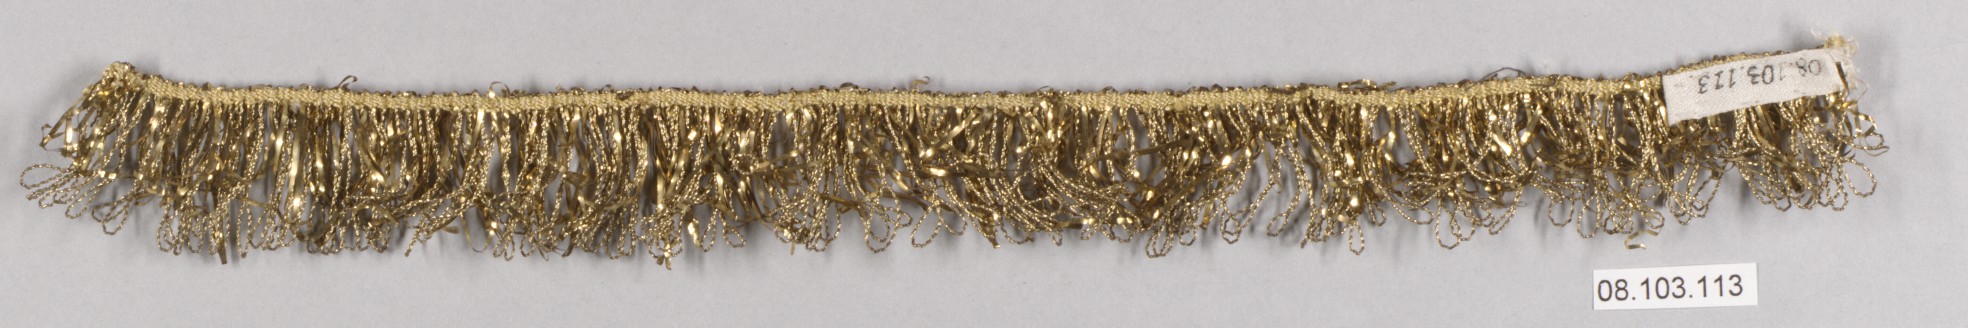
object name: fringe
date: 1801-1833